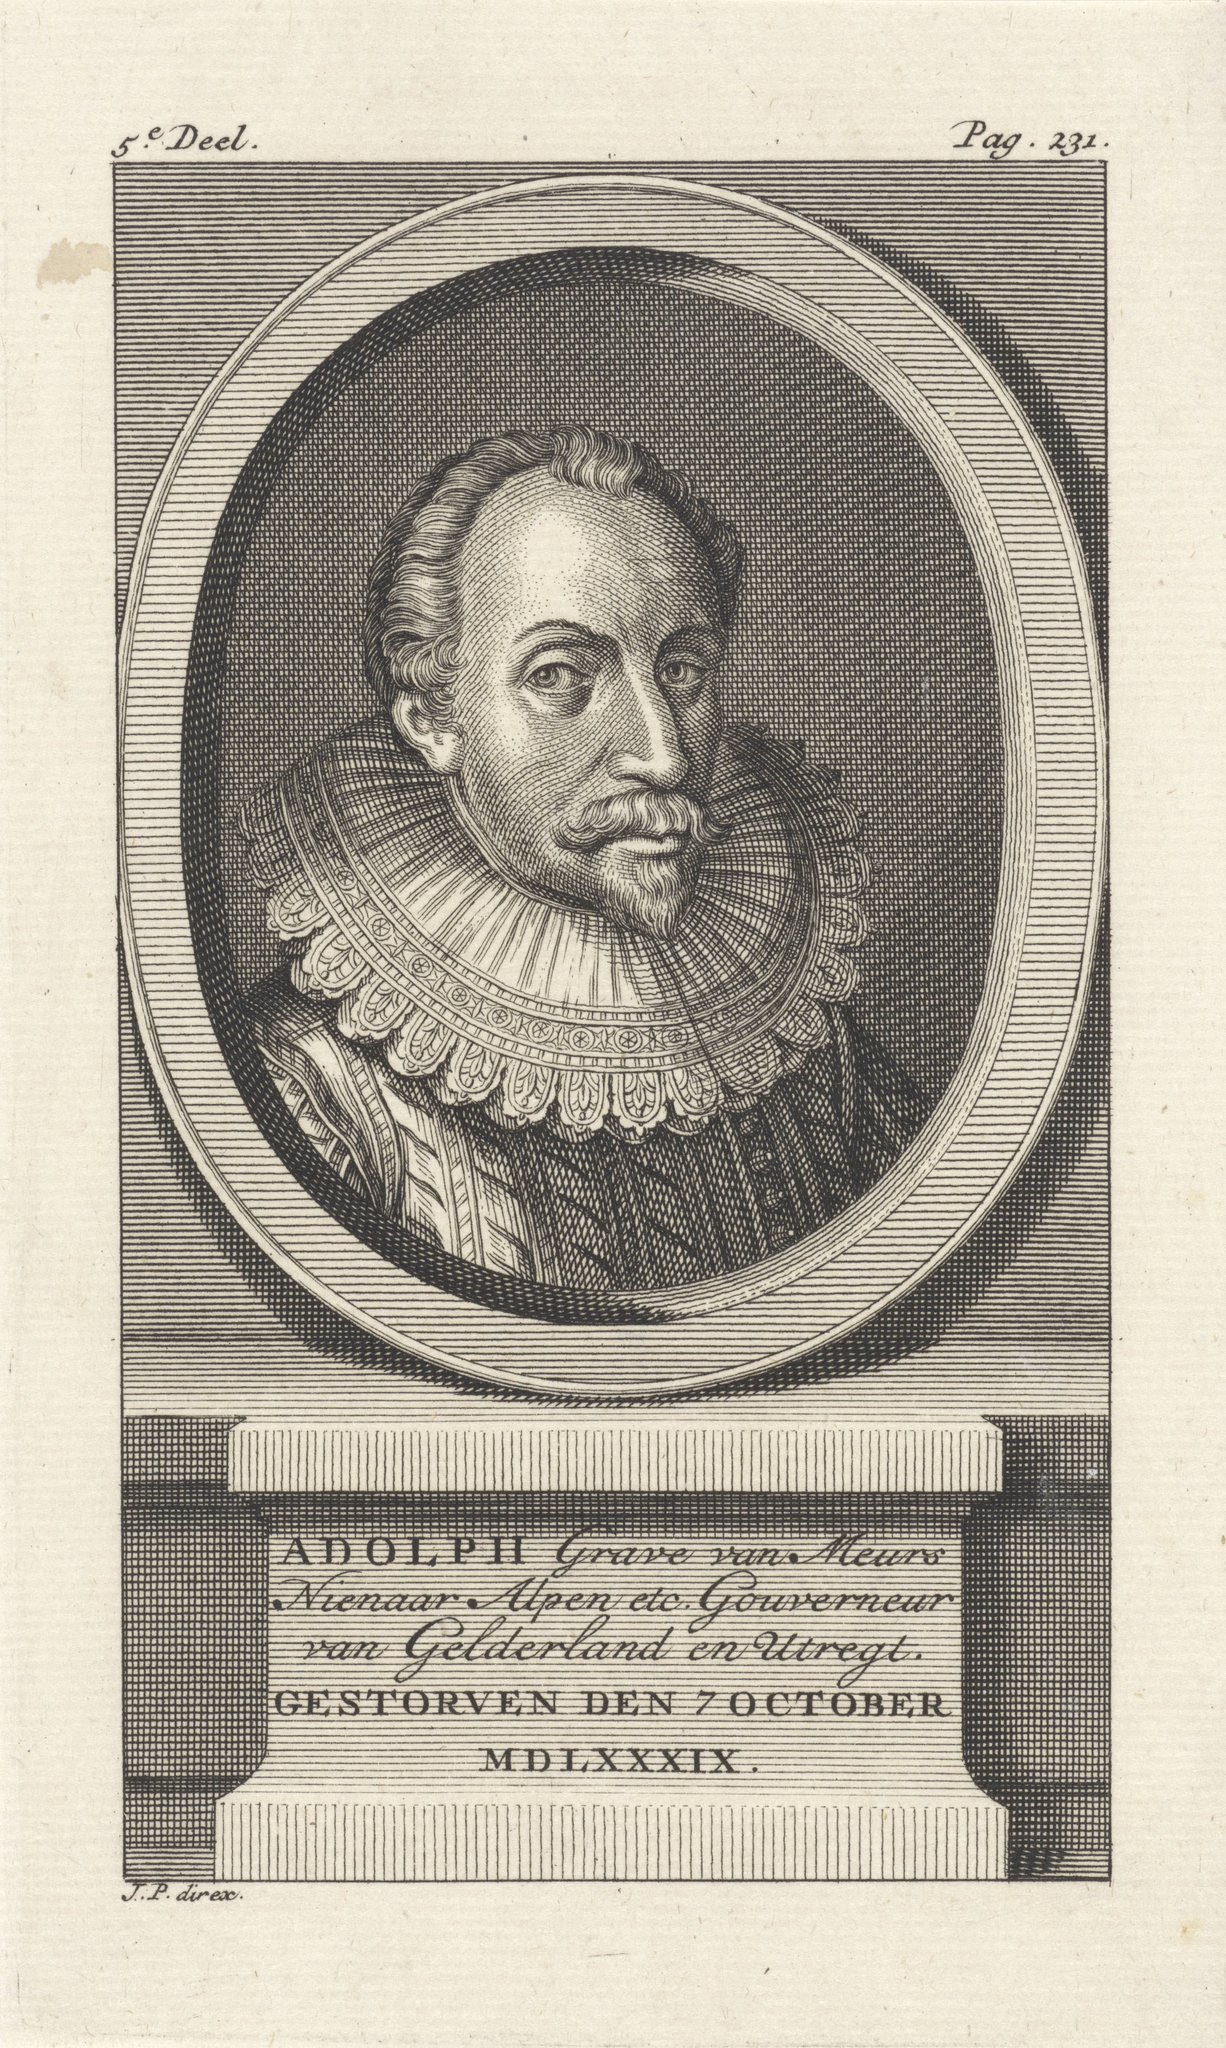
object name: book illustration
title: Portret van Adolf van Nieuwenaar, graaf van Limburg en Meurs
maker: jan punt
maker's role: draughtsman, print maker, publisher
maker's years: 1711-1779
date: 1752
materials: paper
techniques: engraving, etching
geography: northern netherlands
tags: arnhem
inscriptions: collector's mark: Lugt 2228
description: Illustratie uit: Meteren, Emanuel van. Historie van de oorlogen en geschiedenissen der Nederlanderen, en der zelver naburen: beginnende met den jare 1315, en eindigende met den jare 1611, deel V, p. 231. Gorinchem: weduwe Nicolaas Goetzee, 1752.